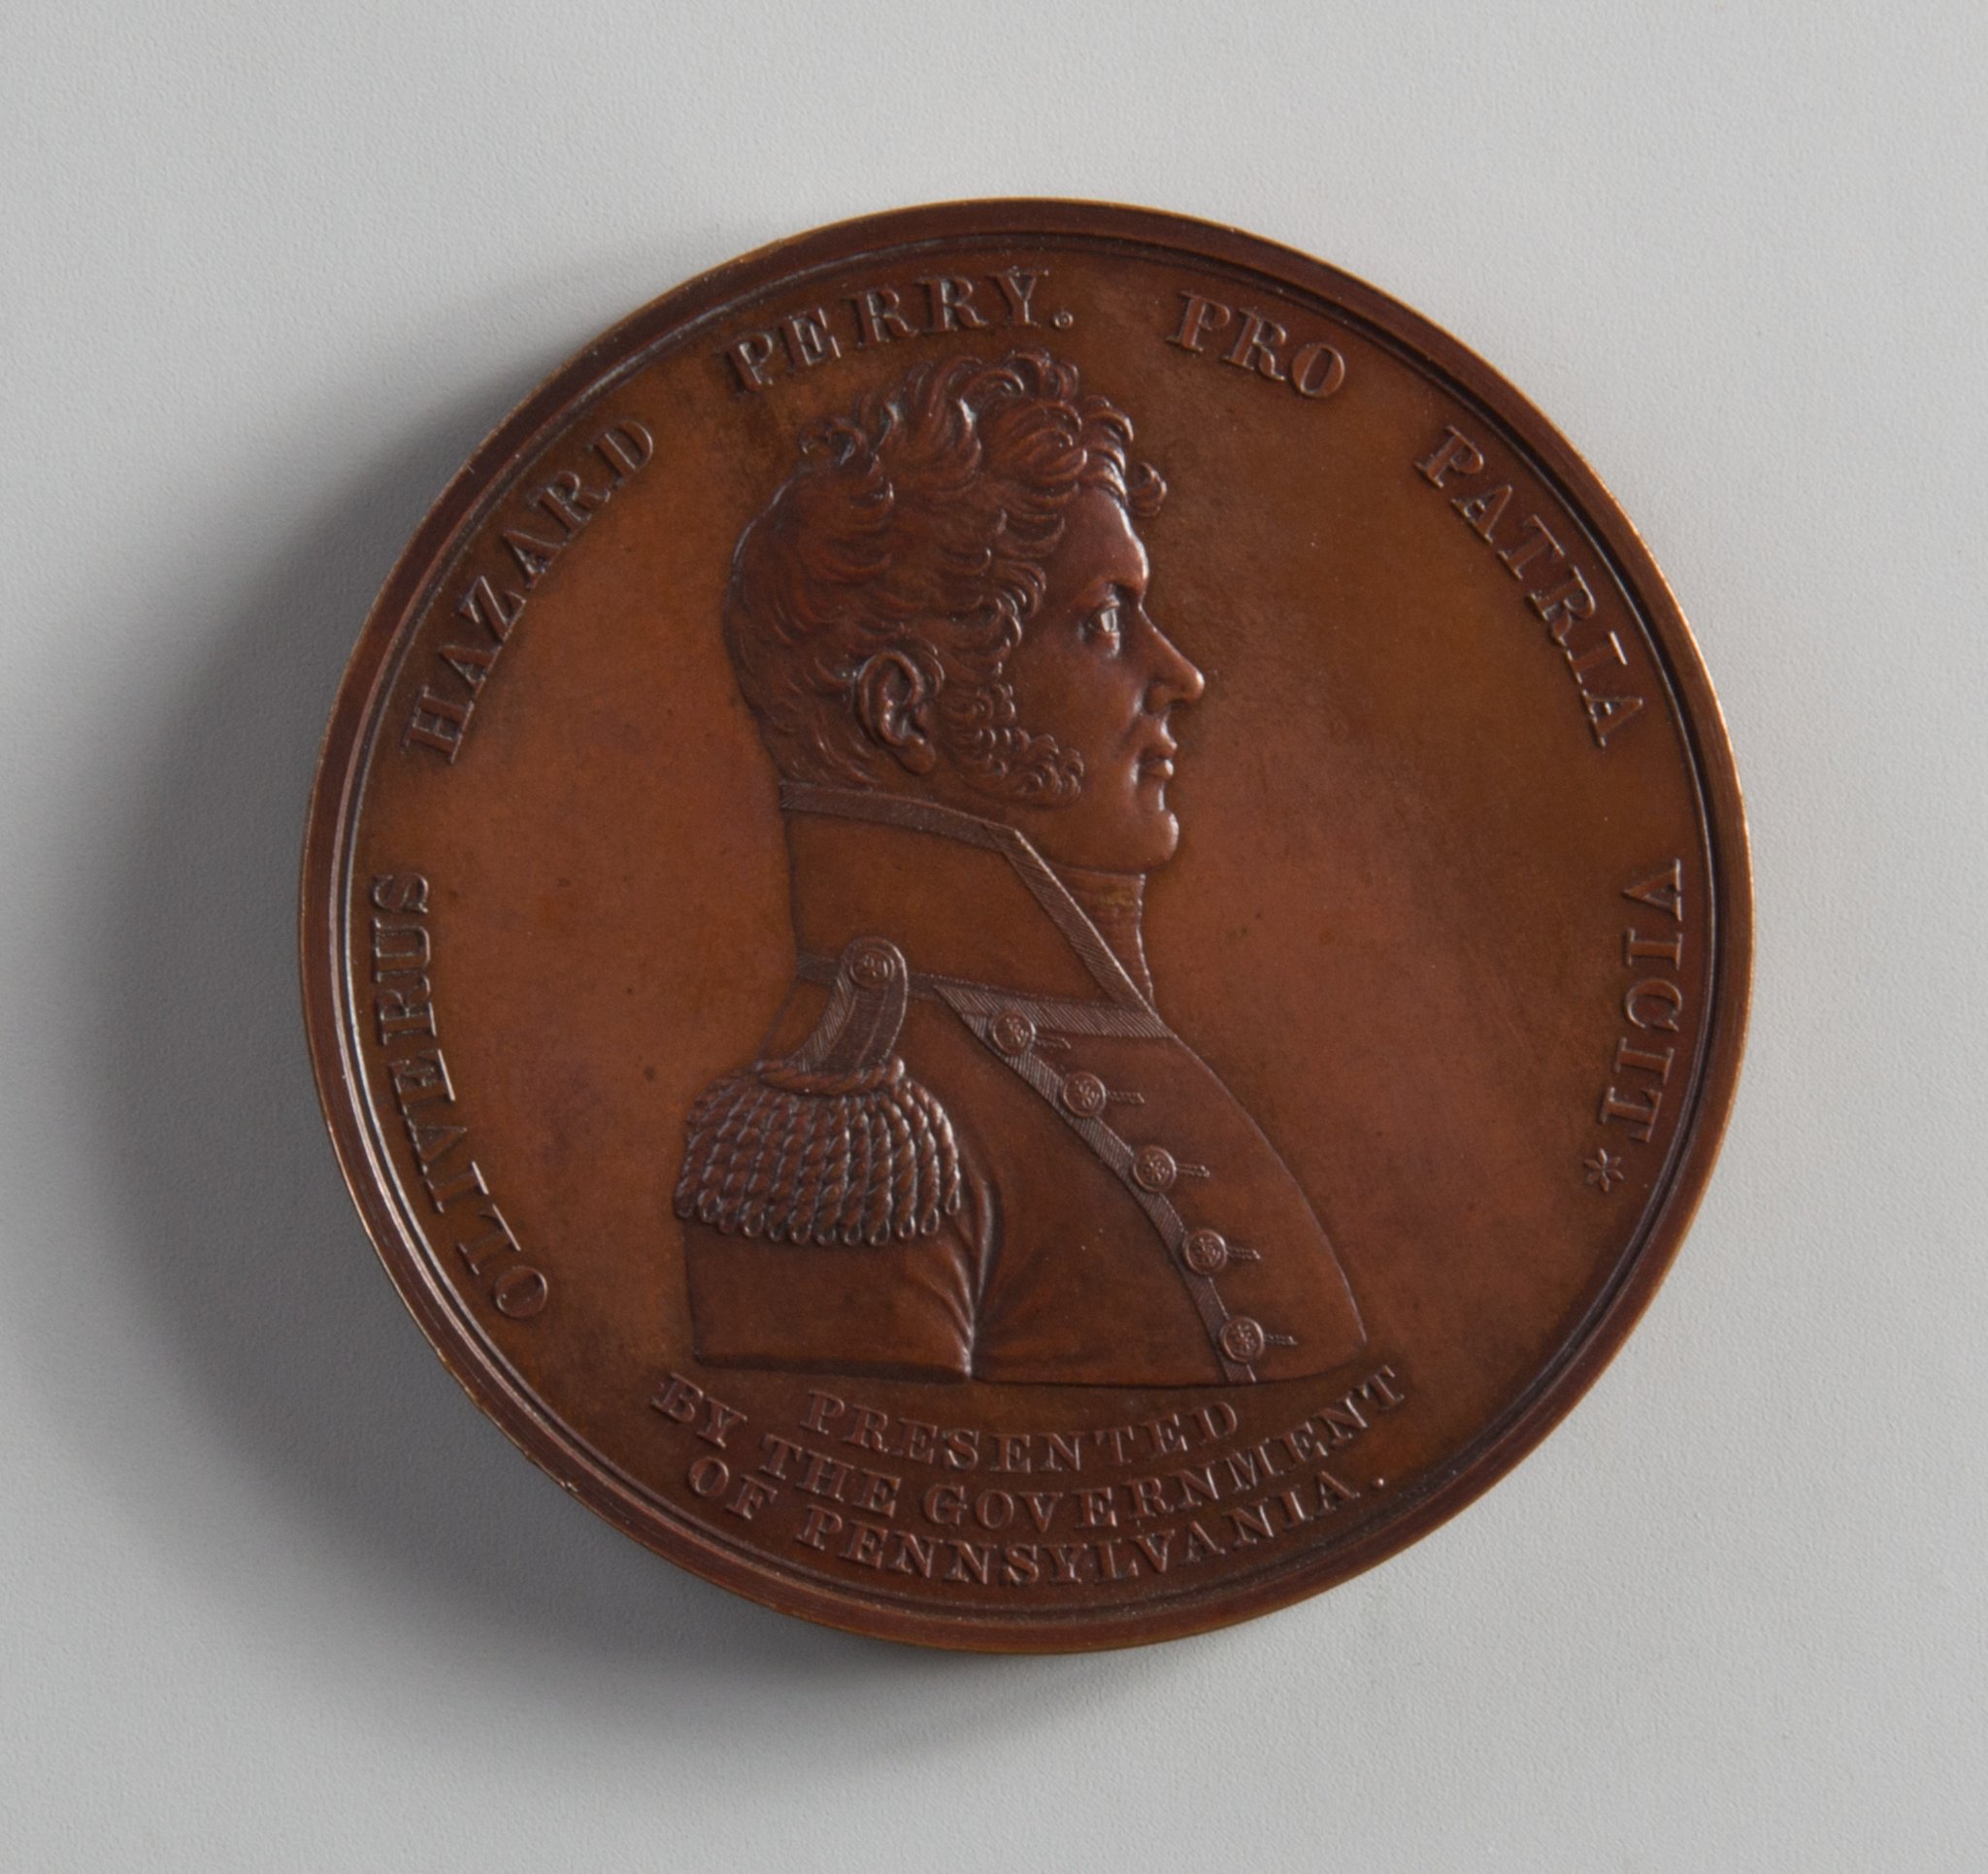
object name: medal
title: Medal of Captain O. H. Perry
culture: american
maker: moritz fürst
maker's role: maker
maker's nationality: hungarian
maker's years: 1782-1882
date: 1813-1815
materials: bronze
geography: united states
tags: men,portraits,profiles